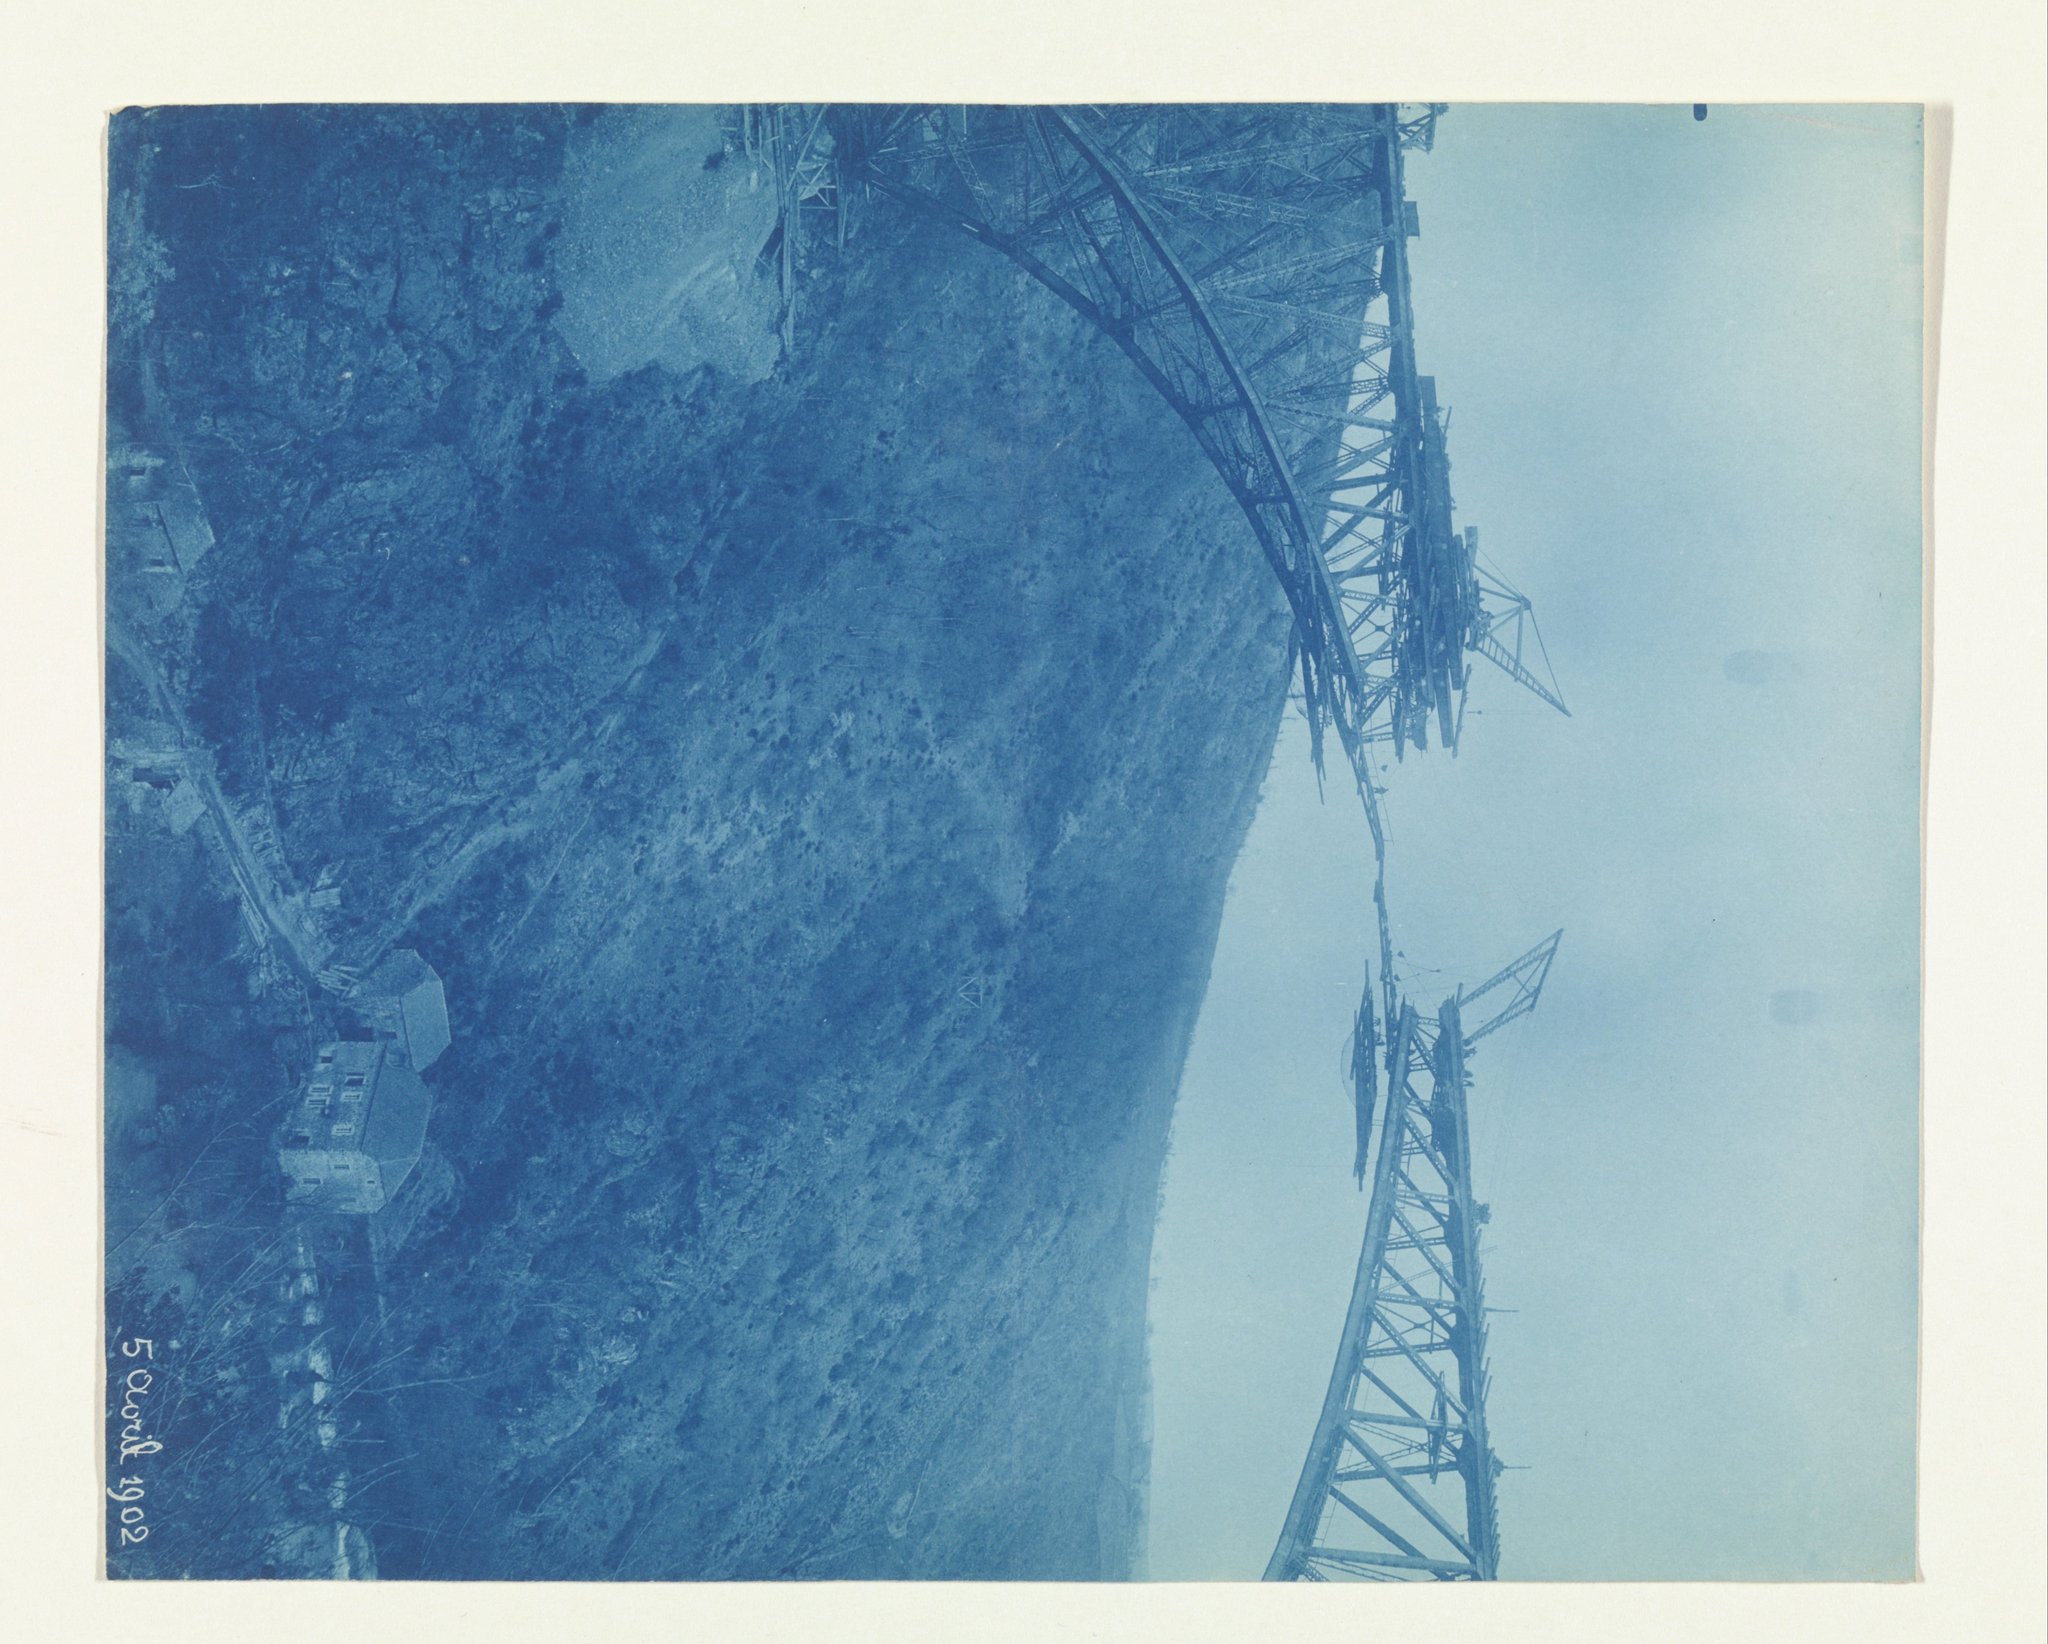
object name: photograph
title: Aanleg van het Viaur Viaduct in Frankrijk door de Societé de Construction des Battignolles, 5 april 1902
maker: Anonymous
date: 1902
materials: photographic support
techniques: cyanotype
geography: france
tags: viaduct, making the overground structures (~ building activities)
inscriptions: date